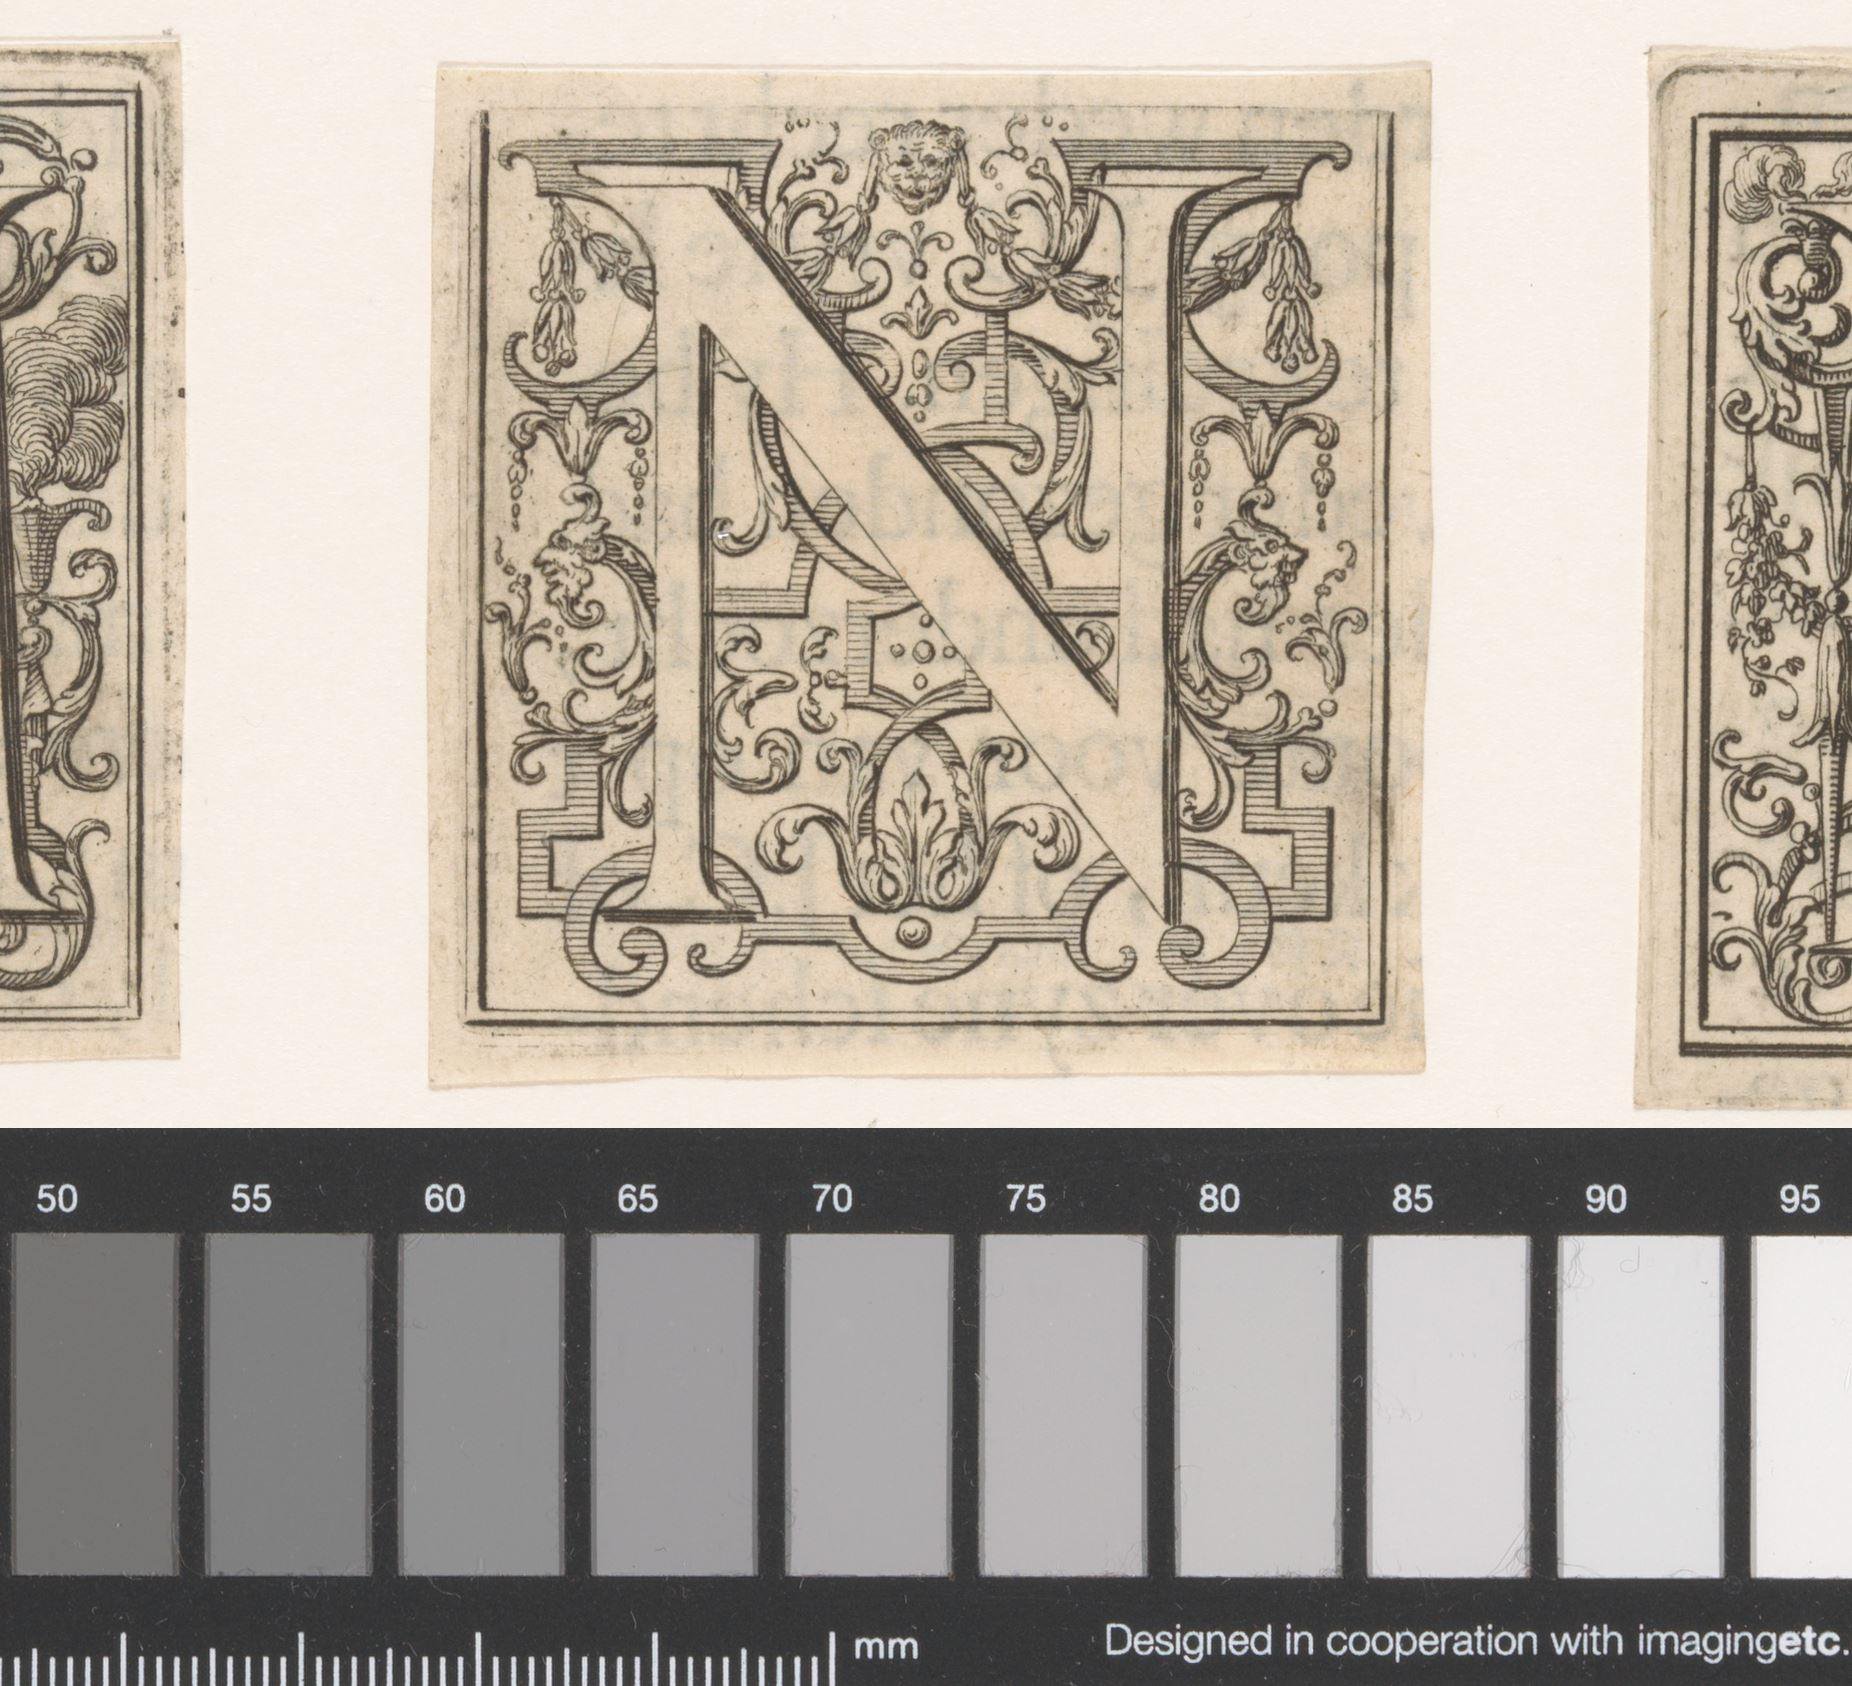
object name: book illustration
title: Letter N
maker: Anonymous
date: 1700-1799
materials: paper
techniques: etching, letterpress printing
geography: netherlands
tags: fancy letters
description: Letter N tegen een achtergrond met vlechtwerk en rookvaten onder een baldakijn.